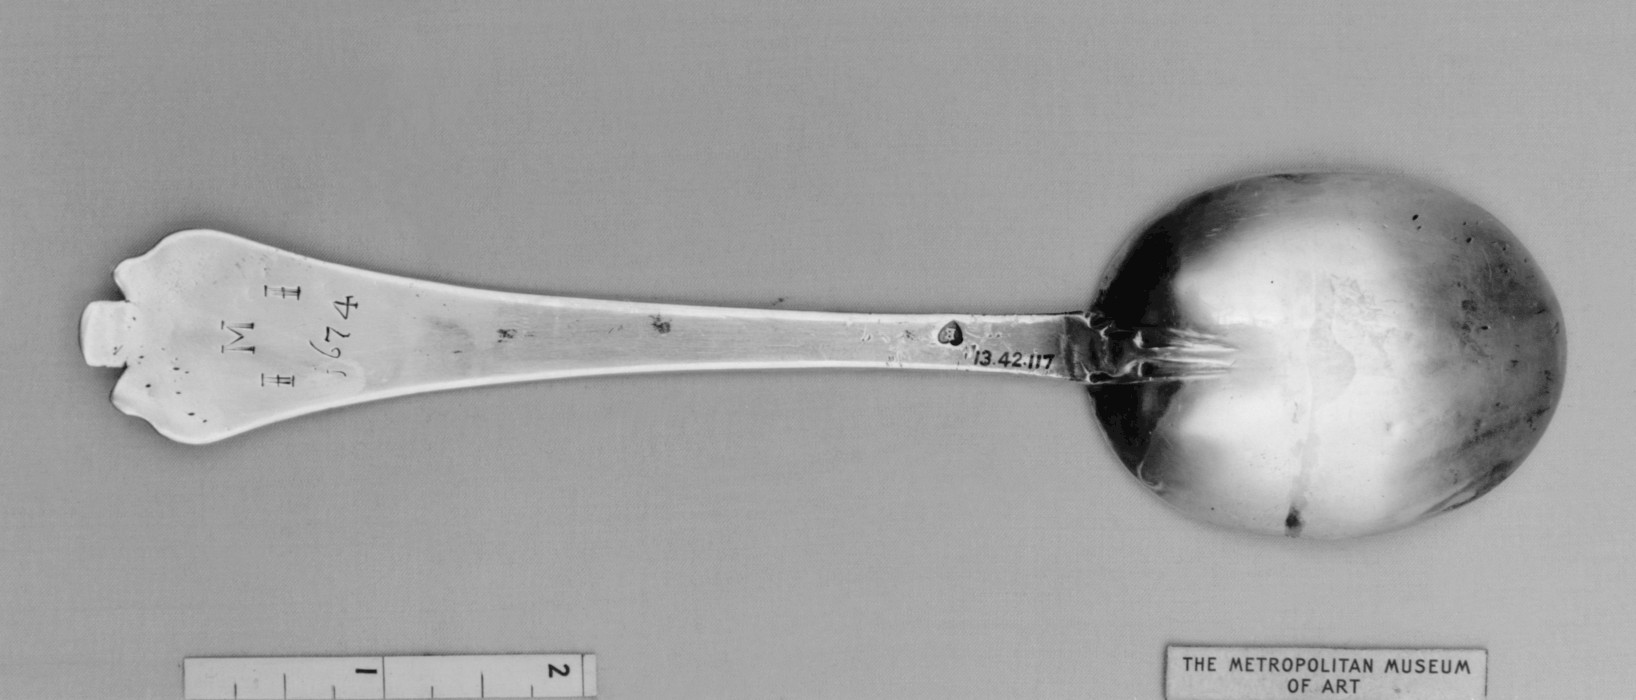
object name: spoon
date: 1601-1700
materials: silver